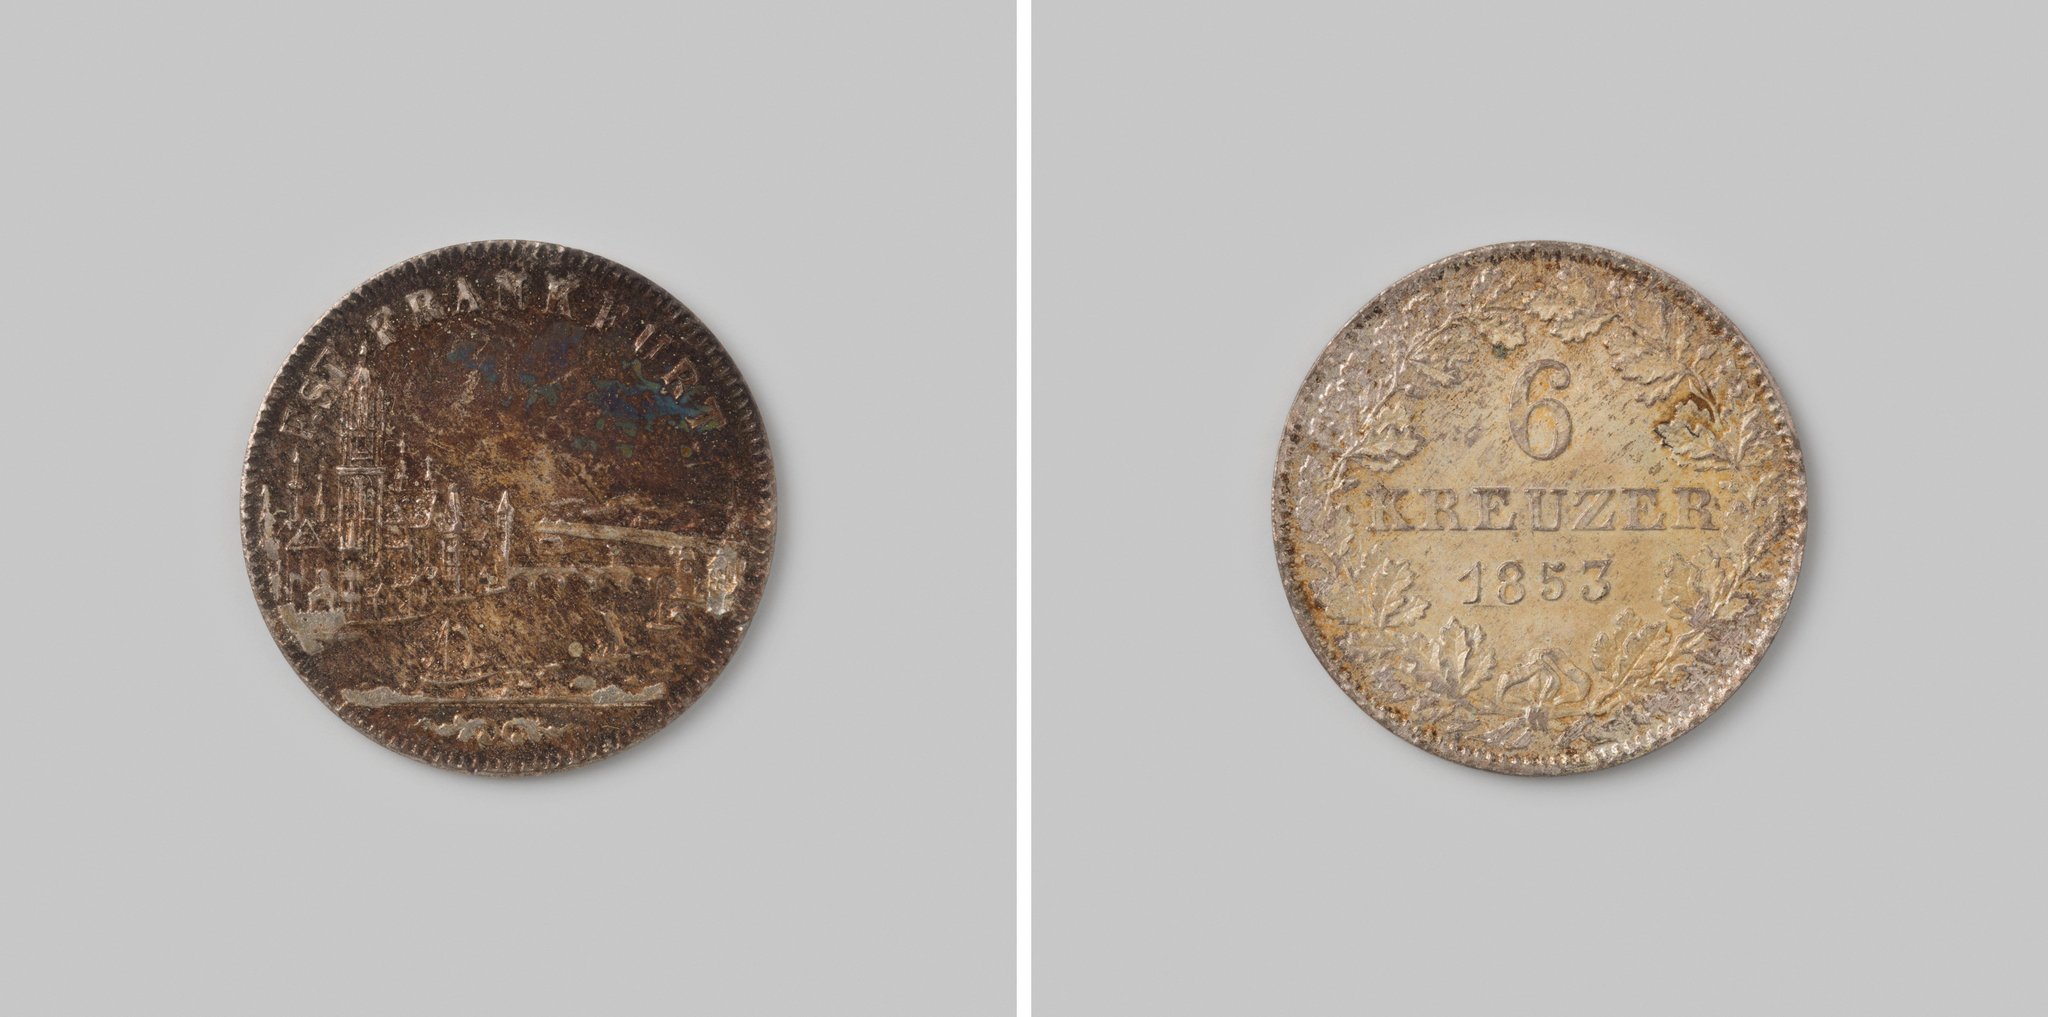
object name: coin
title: 6 Kreuzer van de vrije rijksstad Frankfurt am Main, 1853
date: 1853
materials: silver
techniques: striking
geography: frankfurt am main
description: Zilveren munt. Voorzijde: stadsgezicht met in afsnede versiering. Keerzijde: binnen twee samengebonden eiketakken in twee regels waarde-aanduiding, waaronder jaartal. Kartelrand.